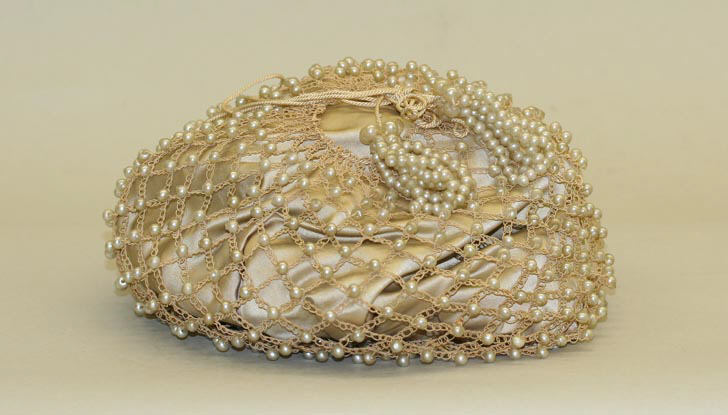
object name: cap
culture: american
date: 1800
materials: silk